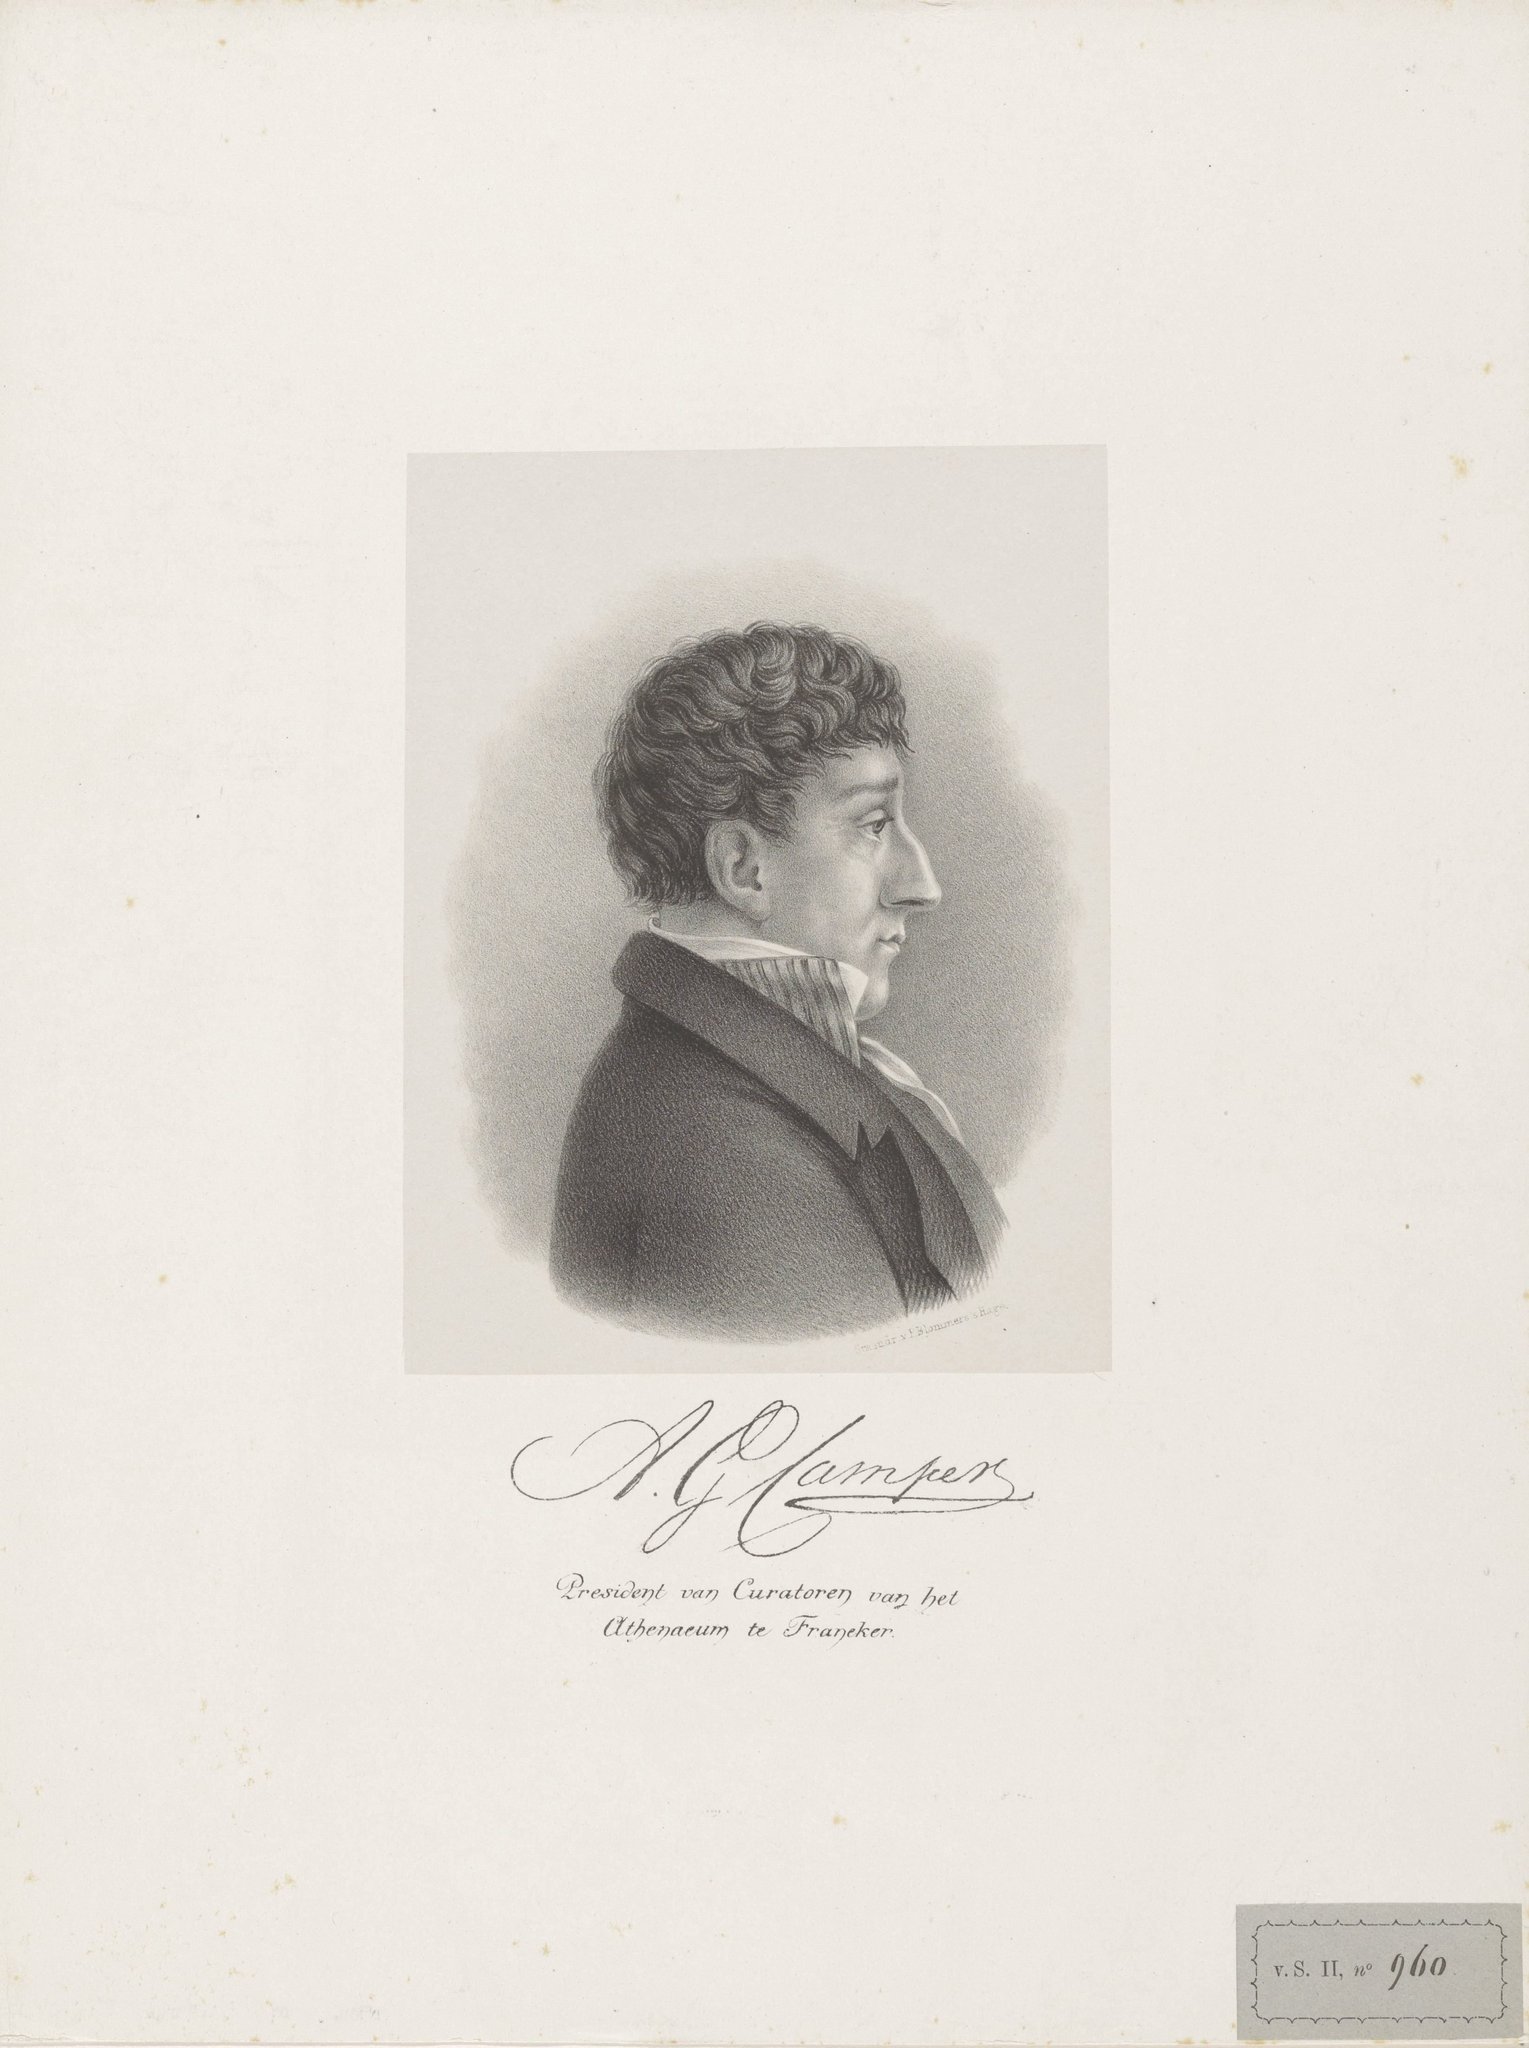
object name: print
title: Portret van A.G. Camper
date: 1842-1887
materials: paper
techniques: lithograph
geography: the hague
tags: historical persons (+ profile portrait)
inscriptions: collector's mark: Lugt 2228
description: De geportretteerde kijkt naar rechts en is en profil afgebeeld. Onder het portret zijn signatuur en functie.